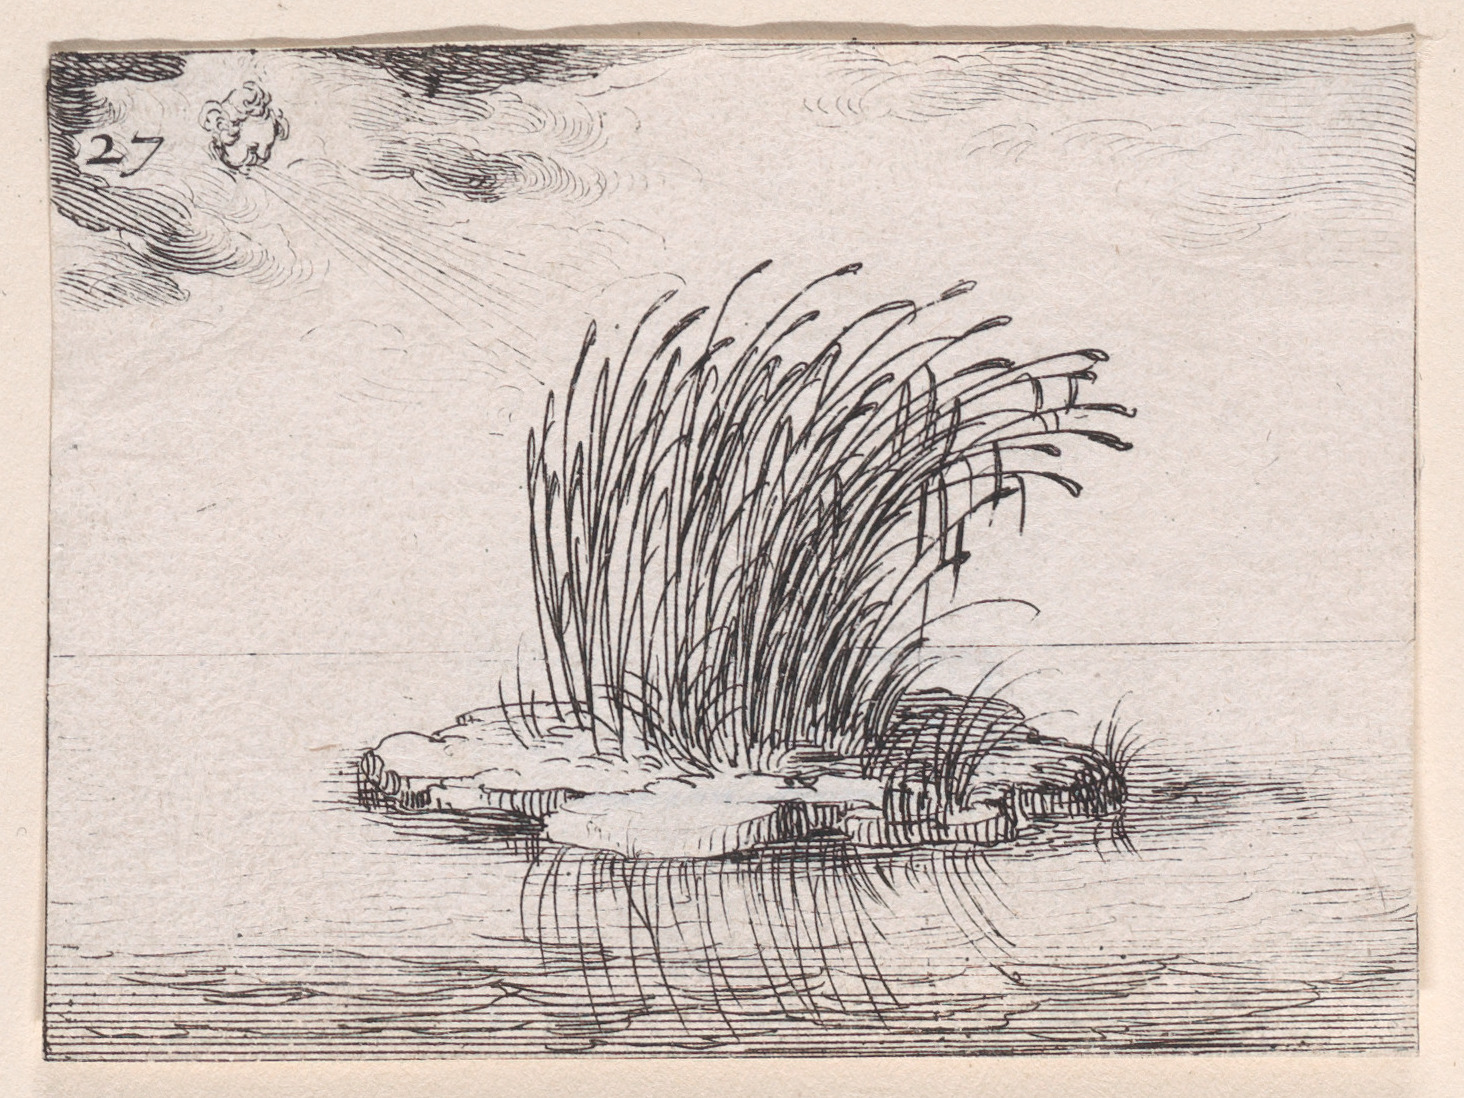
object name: print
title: Les Roseaux et Le Vent (The Reed and The Wind), plate 27 from "Lux Claustri ou La Lumière du Cloitre" (The Light of the Cloisters)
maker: jacques callot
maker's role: artist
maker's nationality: french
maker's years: 1592-1635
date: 1621-1635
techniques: etching